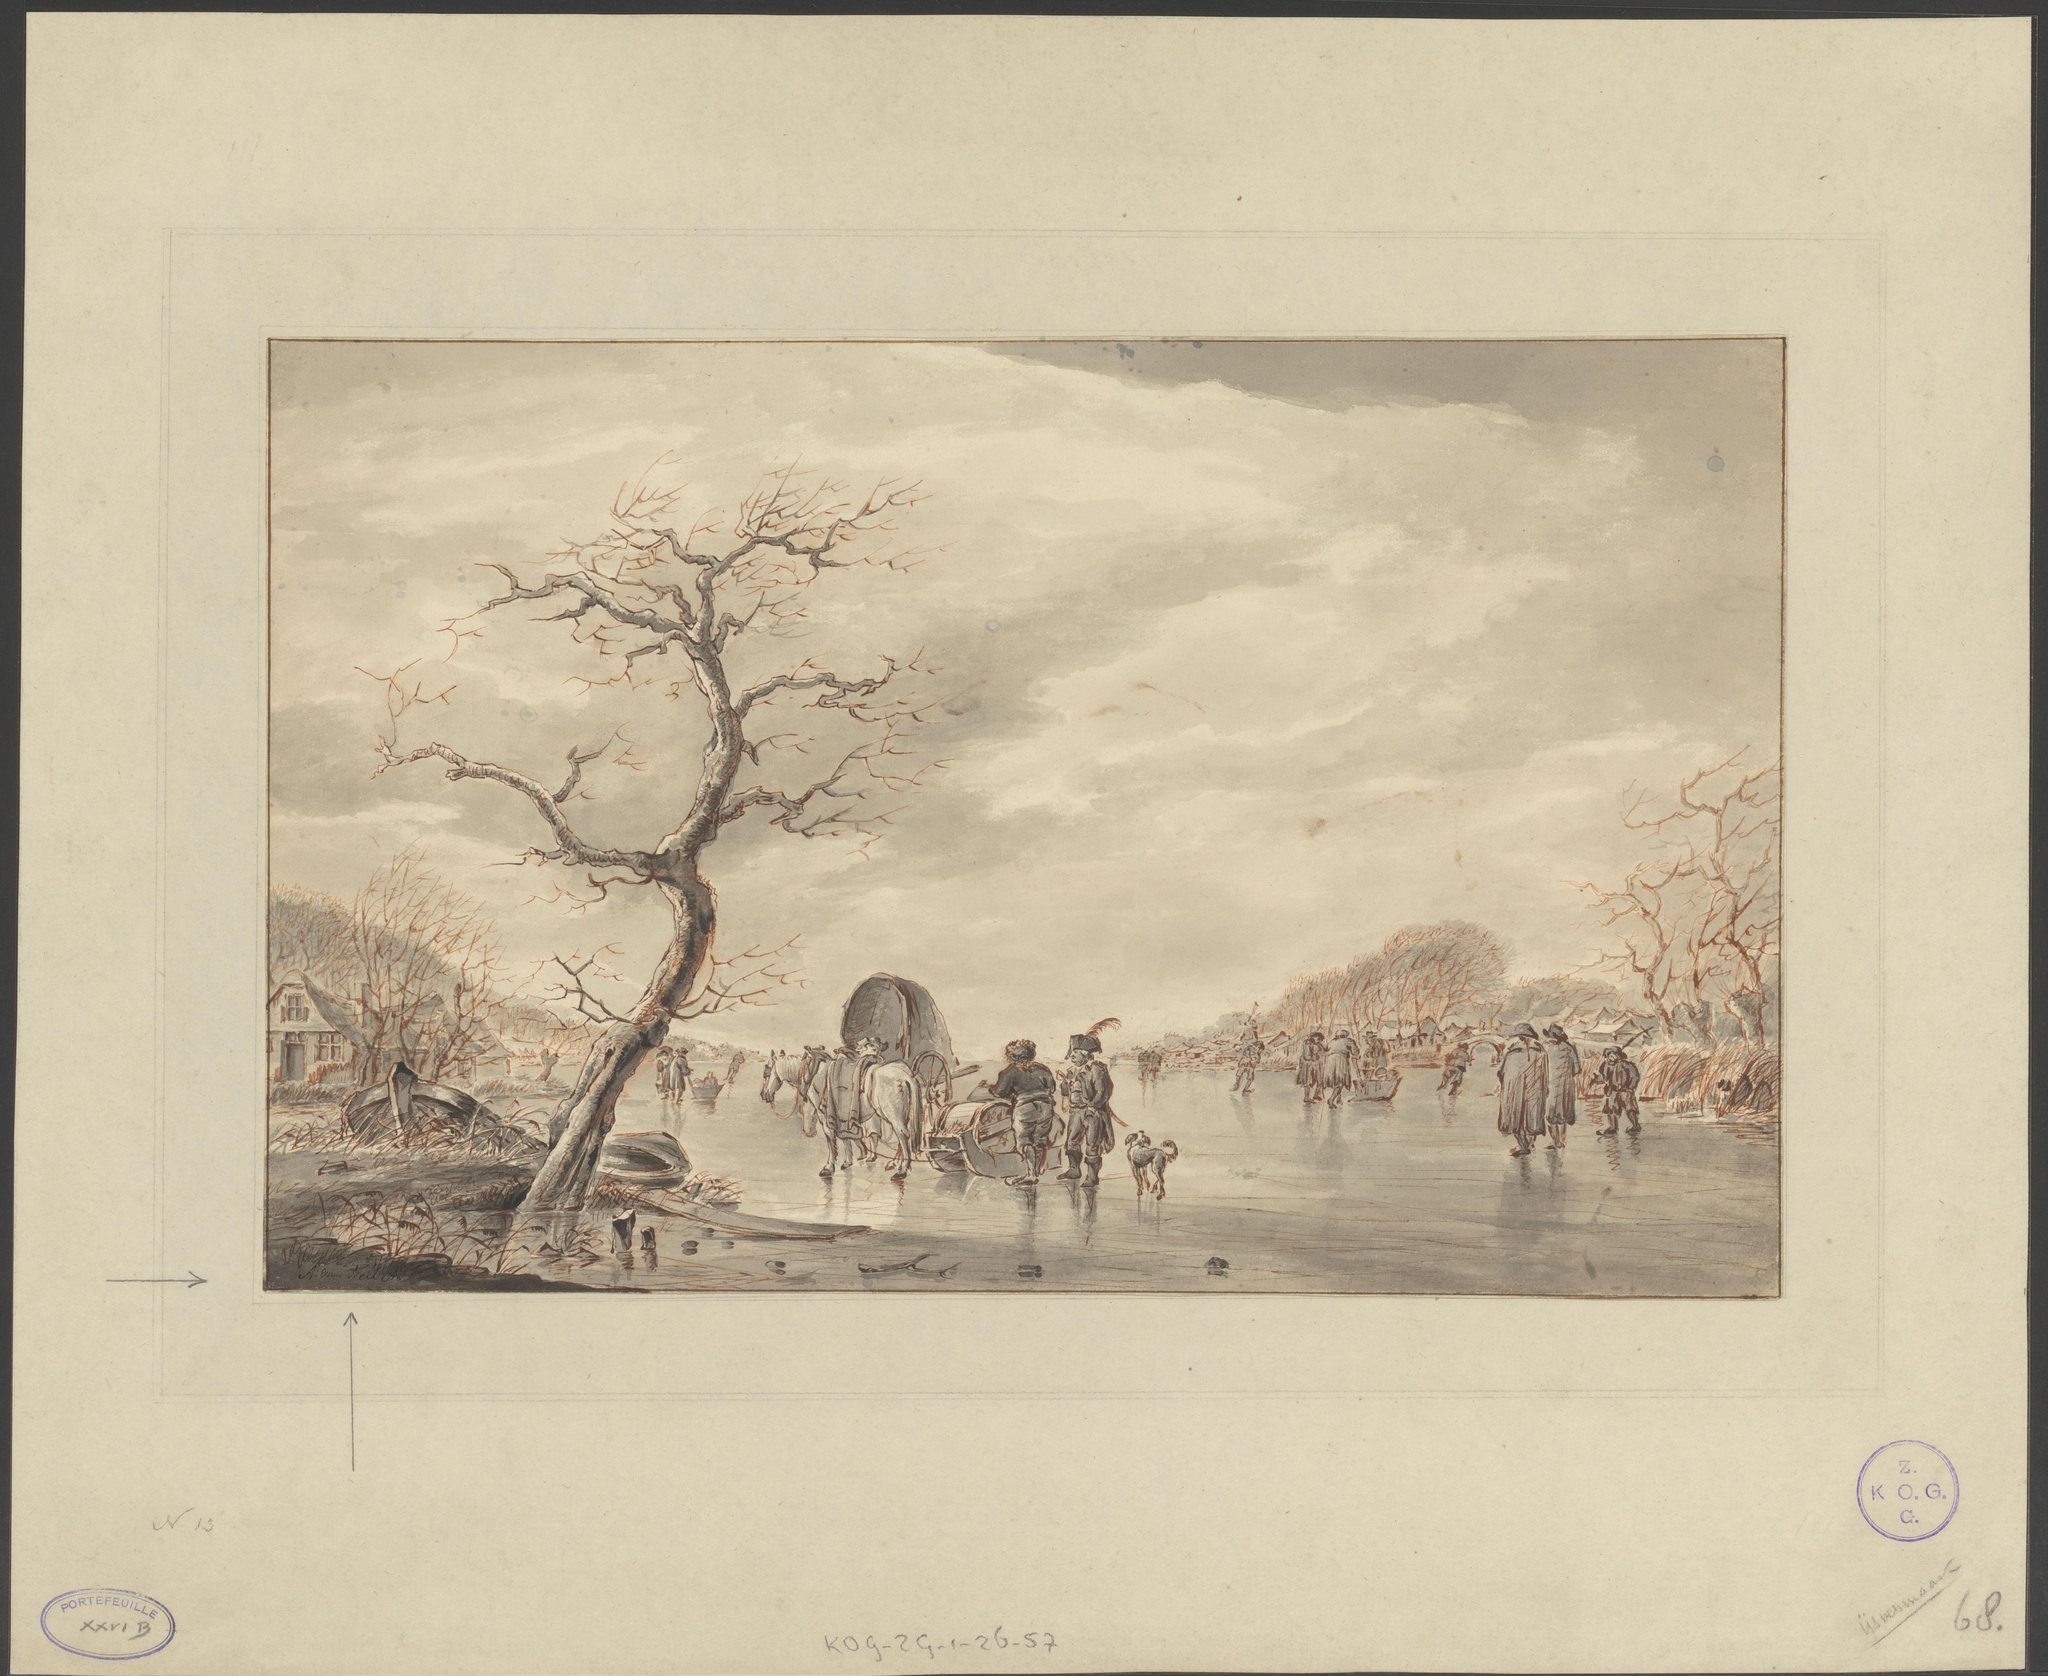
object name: drawing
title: Vrachtslede op het ijs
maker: a. van hell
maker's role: draughtsman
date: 1750-1799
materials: ink, paper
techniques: brush, pen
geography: netherlands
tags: horse-sleigh, winter sports, ice ~ freezing weather, skates (winter sports), sledge, sleigh (winter sports), small sleigh (winter sports)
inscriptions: collector's mark, collector's mark: Lugt 1641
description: Winterlandschap met ijsvermaak en centraal een door een paard getrokken vrachtslede. Verder veel schaatsers op het ijs en enkele baksleden. Onderwerpsrubrieken binnen de Atlas Zeden en Gewoonten: Spel en Vermaak; IJsvermaak, Teekeningen.